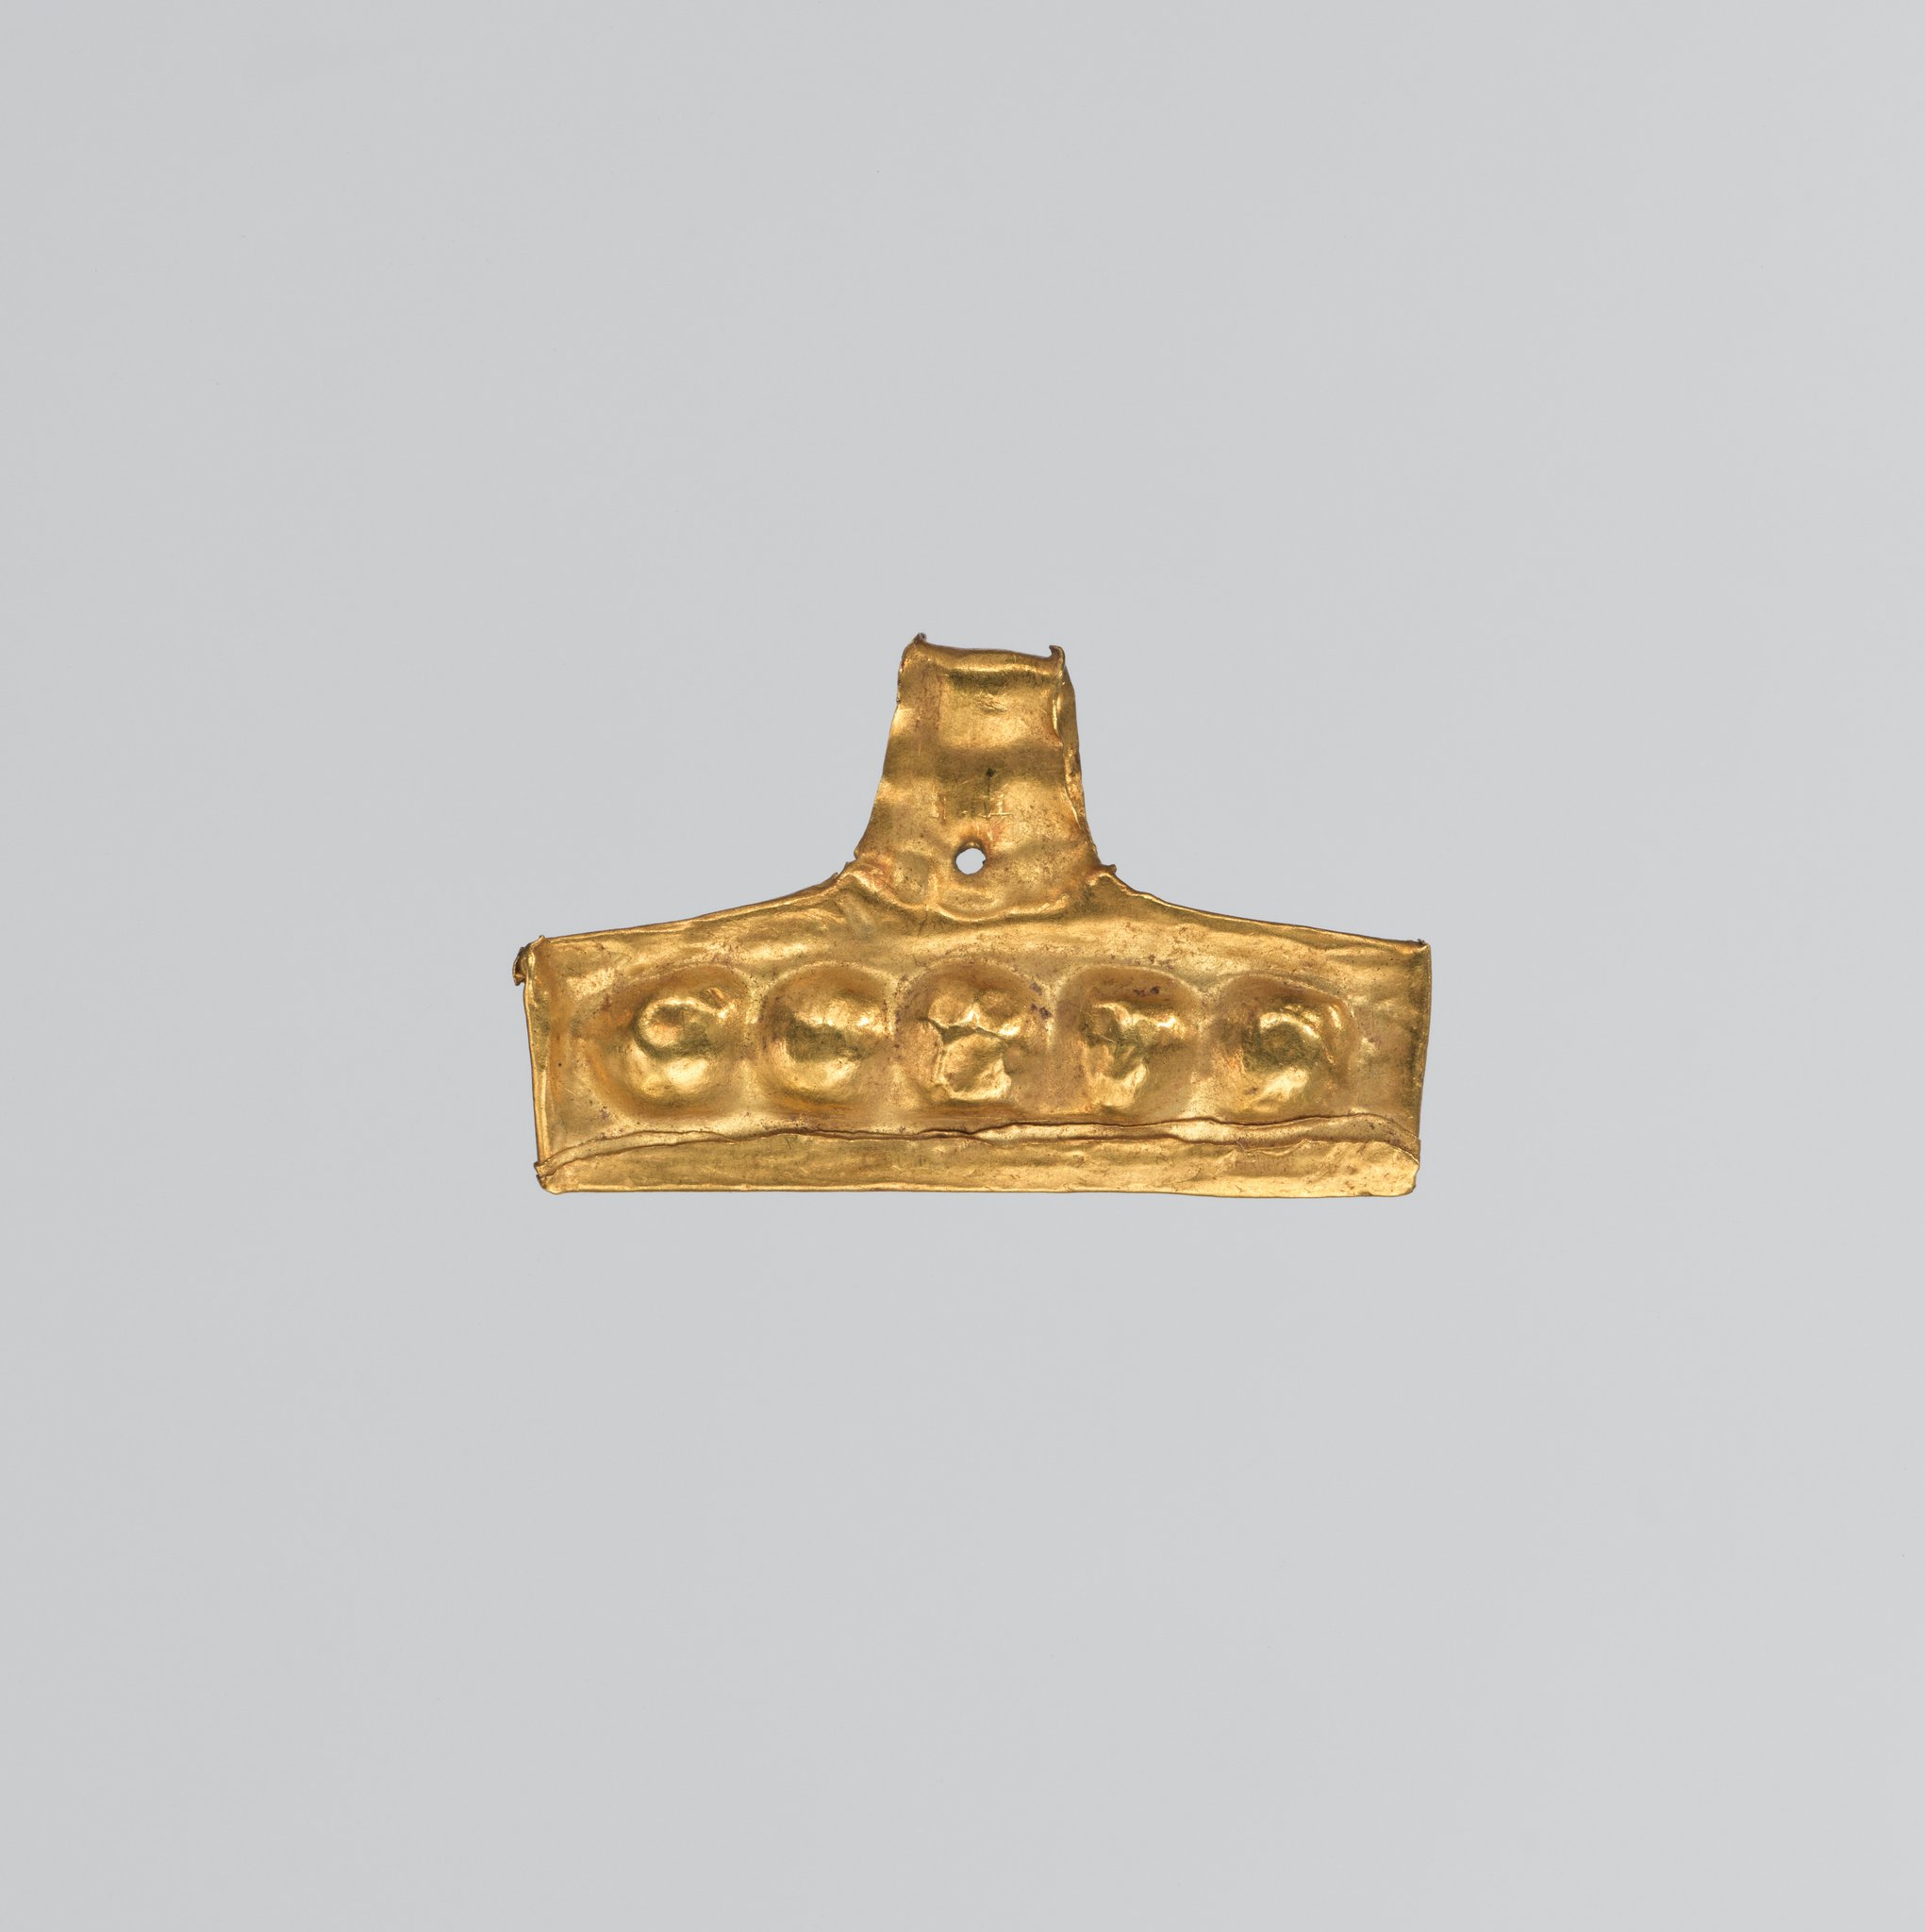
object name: bead pendant, tubular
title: Gold pendant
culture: cypro-phoenician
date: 700-501 BCE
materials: gold